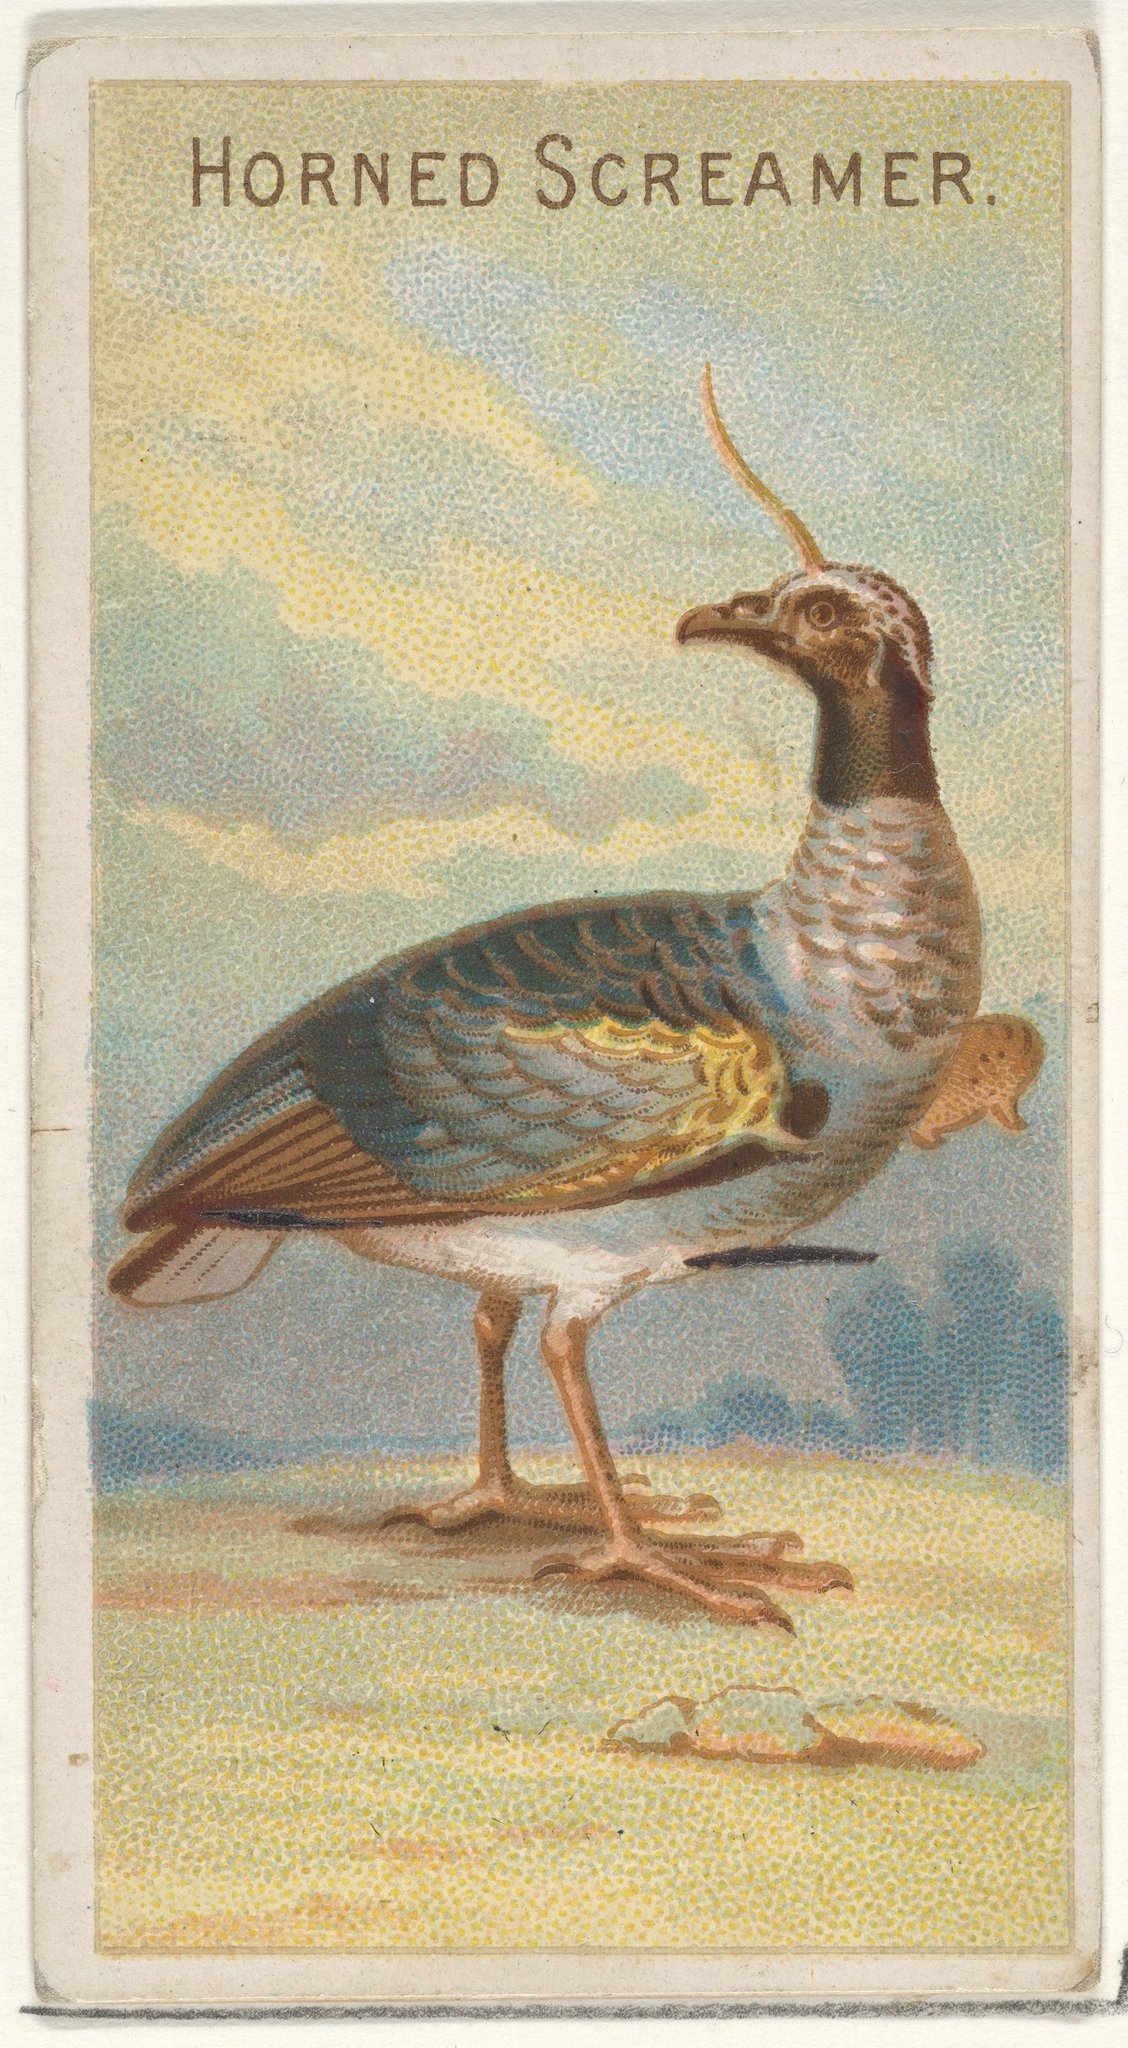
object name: print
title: Horned Screamer, from the Birds of the Tropics series (N5) for Allen & Ginter Cigarettes Brands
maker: allen & ginter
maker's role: publisher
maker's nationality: american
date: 1889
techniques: color lithograph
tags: birds